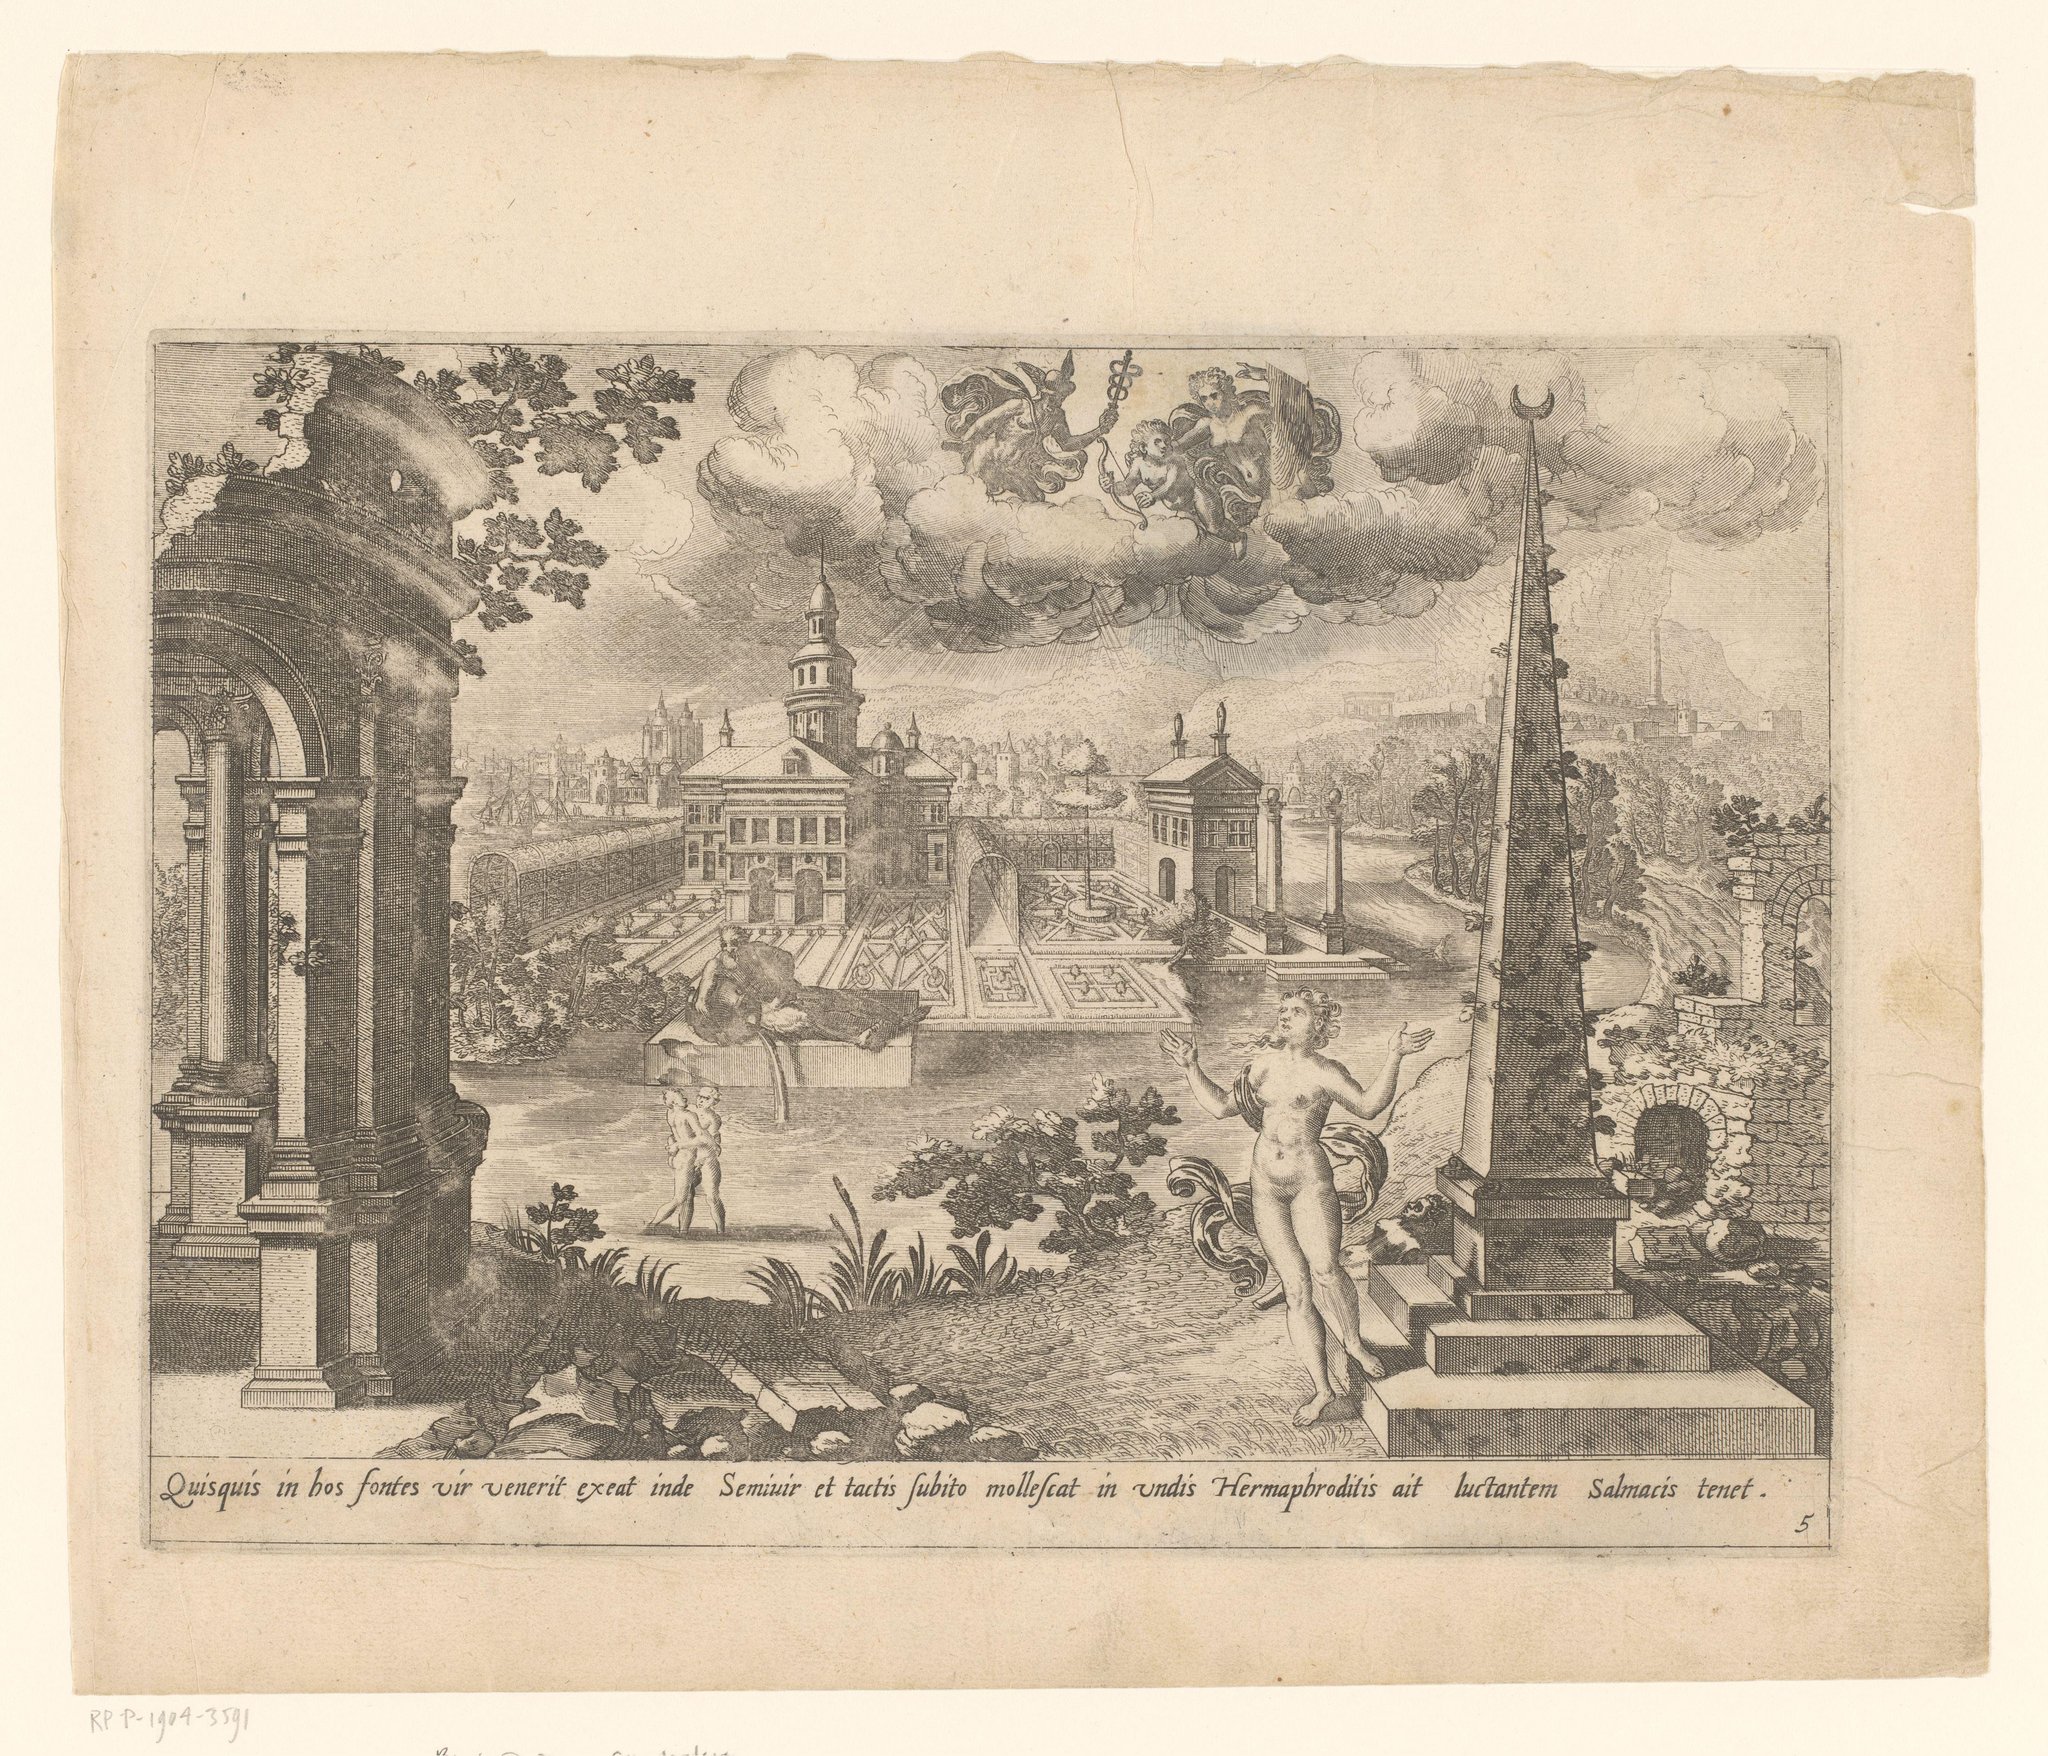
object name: print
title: Metamorfosen van Ovidius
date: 1601-1652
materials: paper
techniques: etching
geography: amsterdam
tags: when hermaphroditus bathes in a fountain, salmacis, the nymph of the fountain, falls in love with him, story of hermaphroditus and salmacis, caduceus (staff with two snakes, attribute of mercury), hermaphroditus and salmacis changed into a hermaphrodite: at the prayer of the fountain-nymph salmacis, who holds the bathing hermaphroditus closely embraced, their bodies fuse (ovid, metamorphoses iv 373), venus and cupid (cupid not being mere attribute)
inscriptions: collector's mark: Lugt 2228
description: De nimf Salmacis staat bij een zuil in een landschap met een tuin. Zij kijkt op naar de wolken waar Mercurius, Venus en Amor verschijnen. Op de achtergrond omhelst Salmacis Hermaphroditus, terwijl ze in het water staan, waarna ze volgens de mythe zouden versmelten tot een tweeslachtig wezen. Onder de voorstelling de tekst uit de Metamorfosen van Ovidius, boek 4, versregels 385-386, in het Latijn.